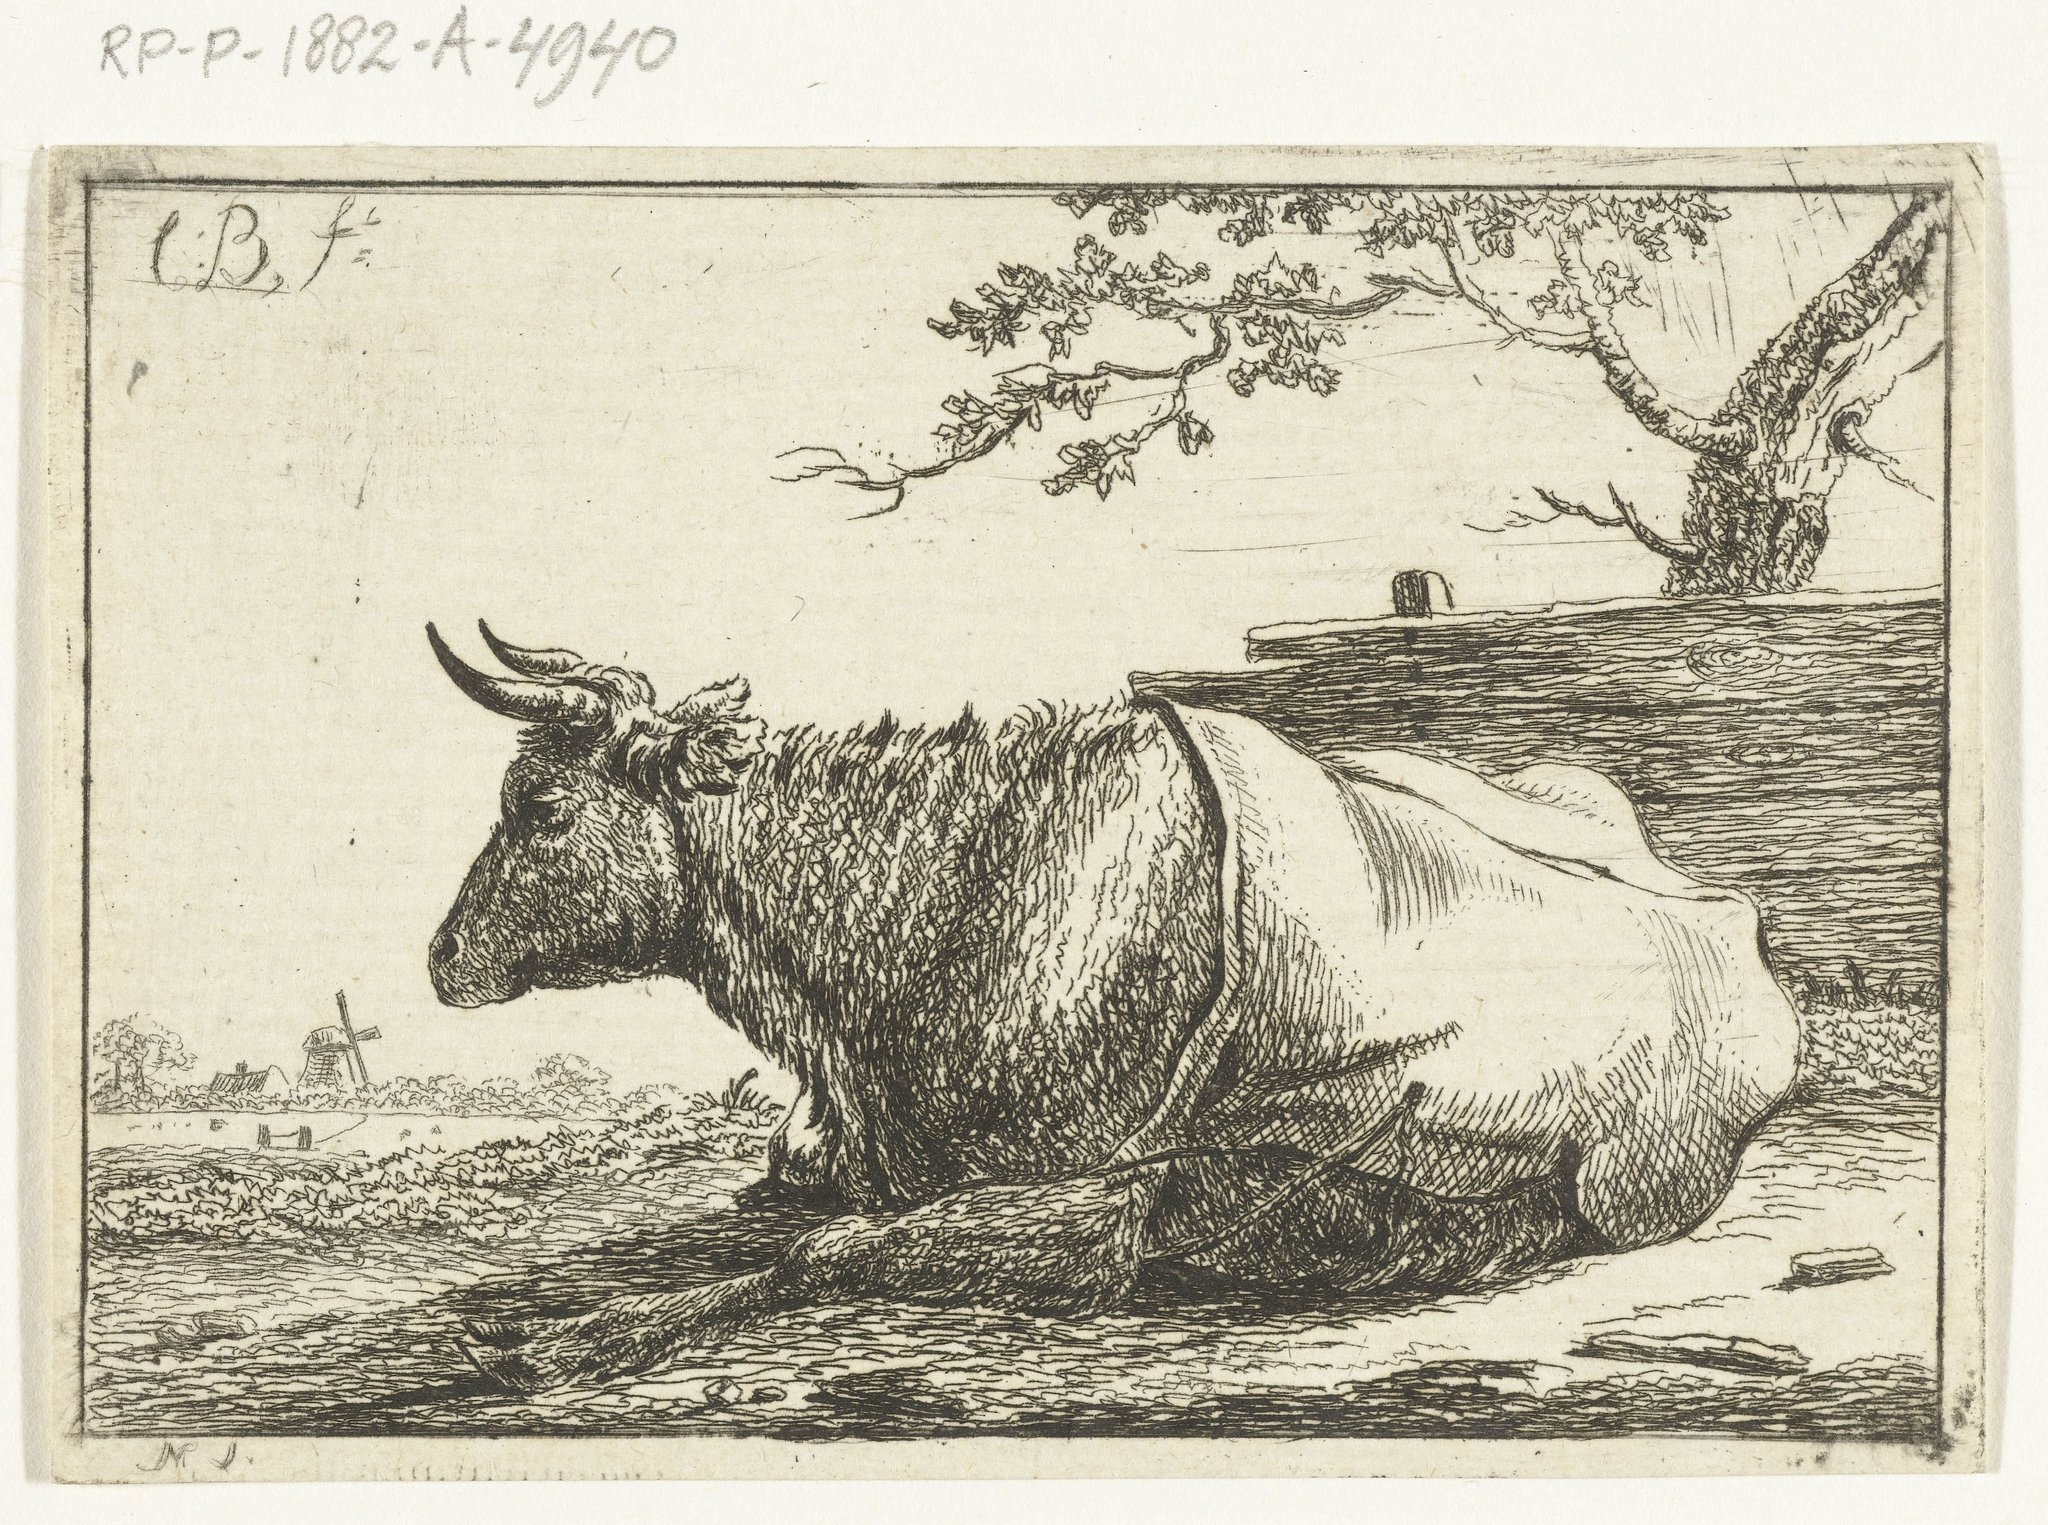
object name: print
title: Landschap met liggende koe met dek op de rug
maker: cornelis bisschop (1762-1829)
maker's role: print maker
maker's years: 1762-1829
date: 1777-1829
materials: paper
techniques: etching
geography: netherlands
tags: cow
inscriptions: collector's mark: Lugt 2228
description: Prent mogelijk uit serie met onbekend aantal prenten van koeien.